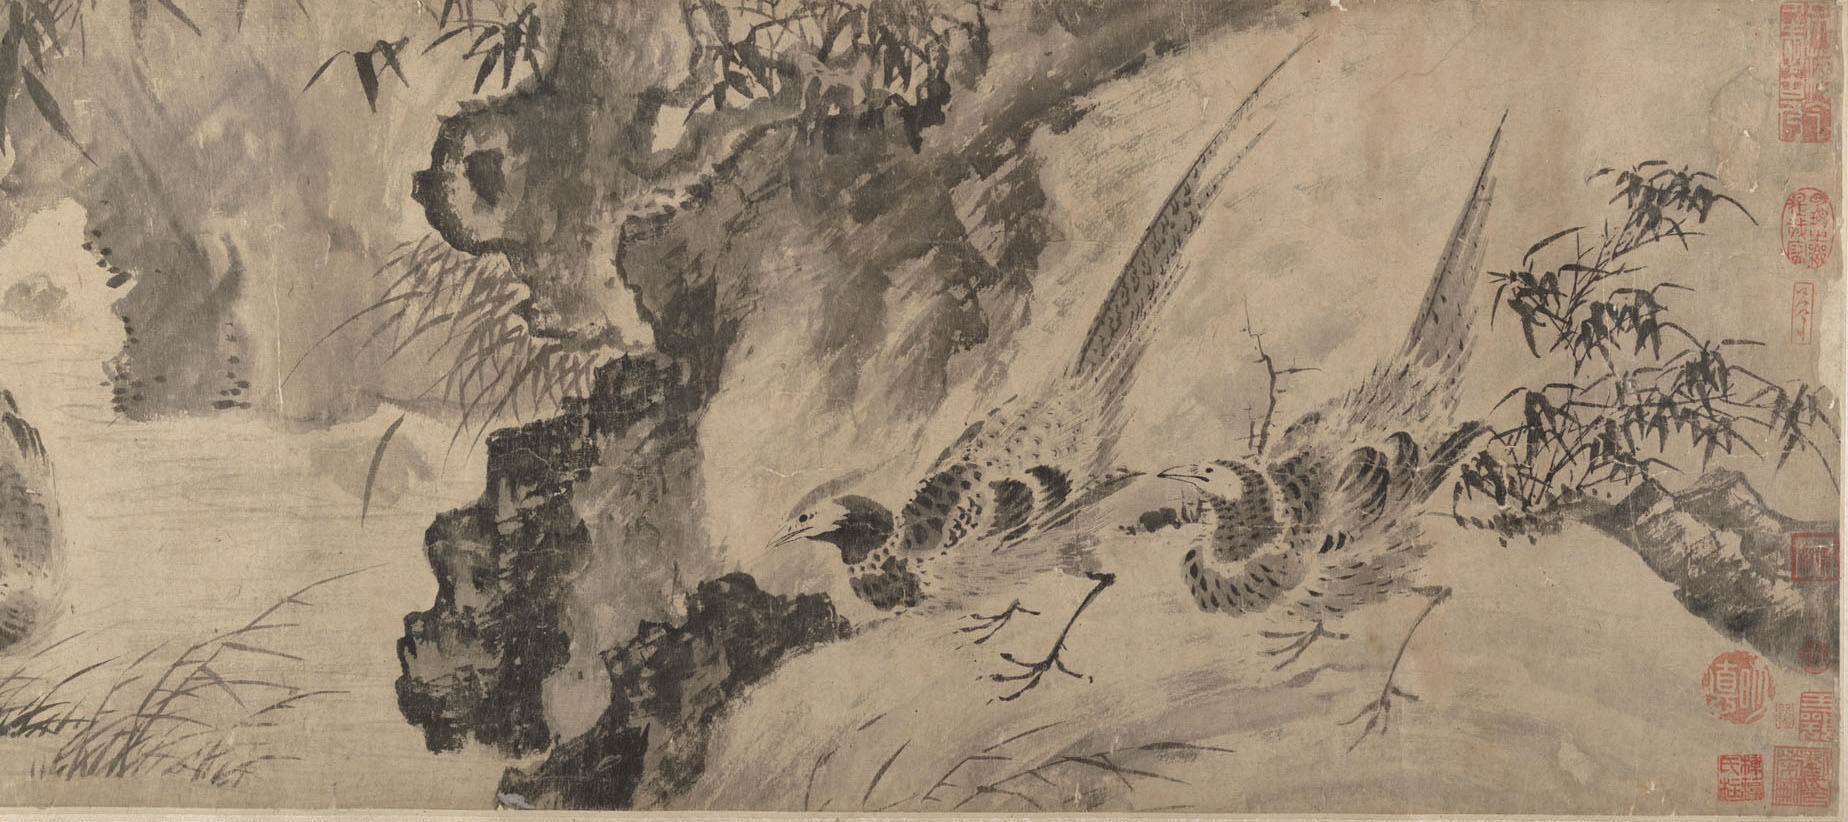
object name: handscroll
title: Marsh Scene with Birds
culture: chinese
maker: shen zhou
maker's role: artist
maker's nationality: chinese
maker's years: 1427-1509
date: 1427-1509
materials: ink, paper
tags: birds